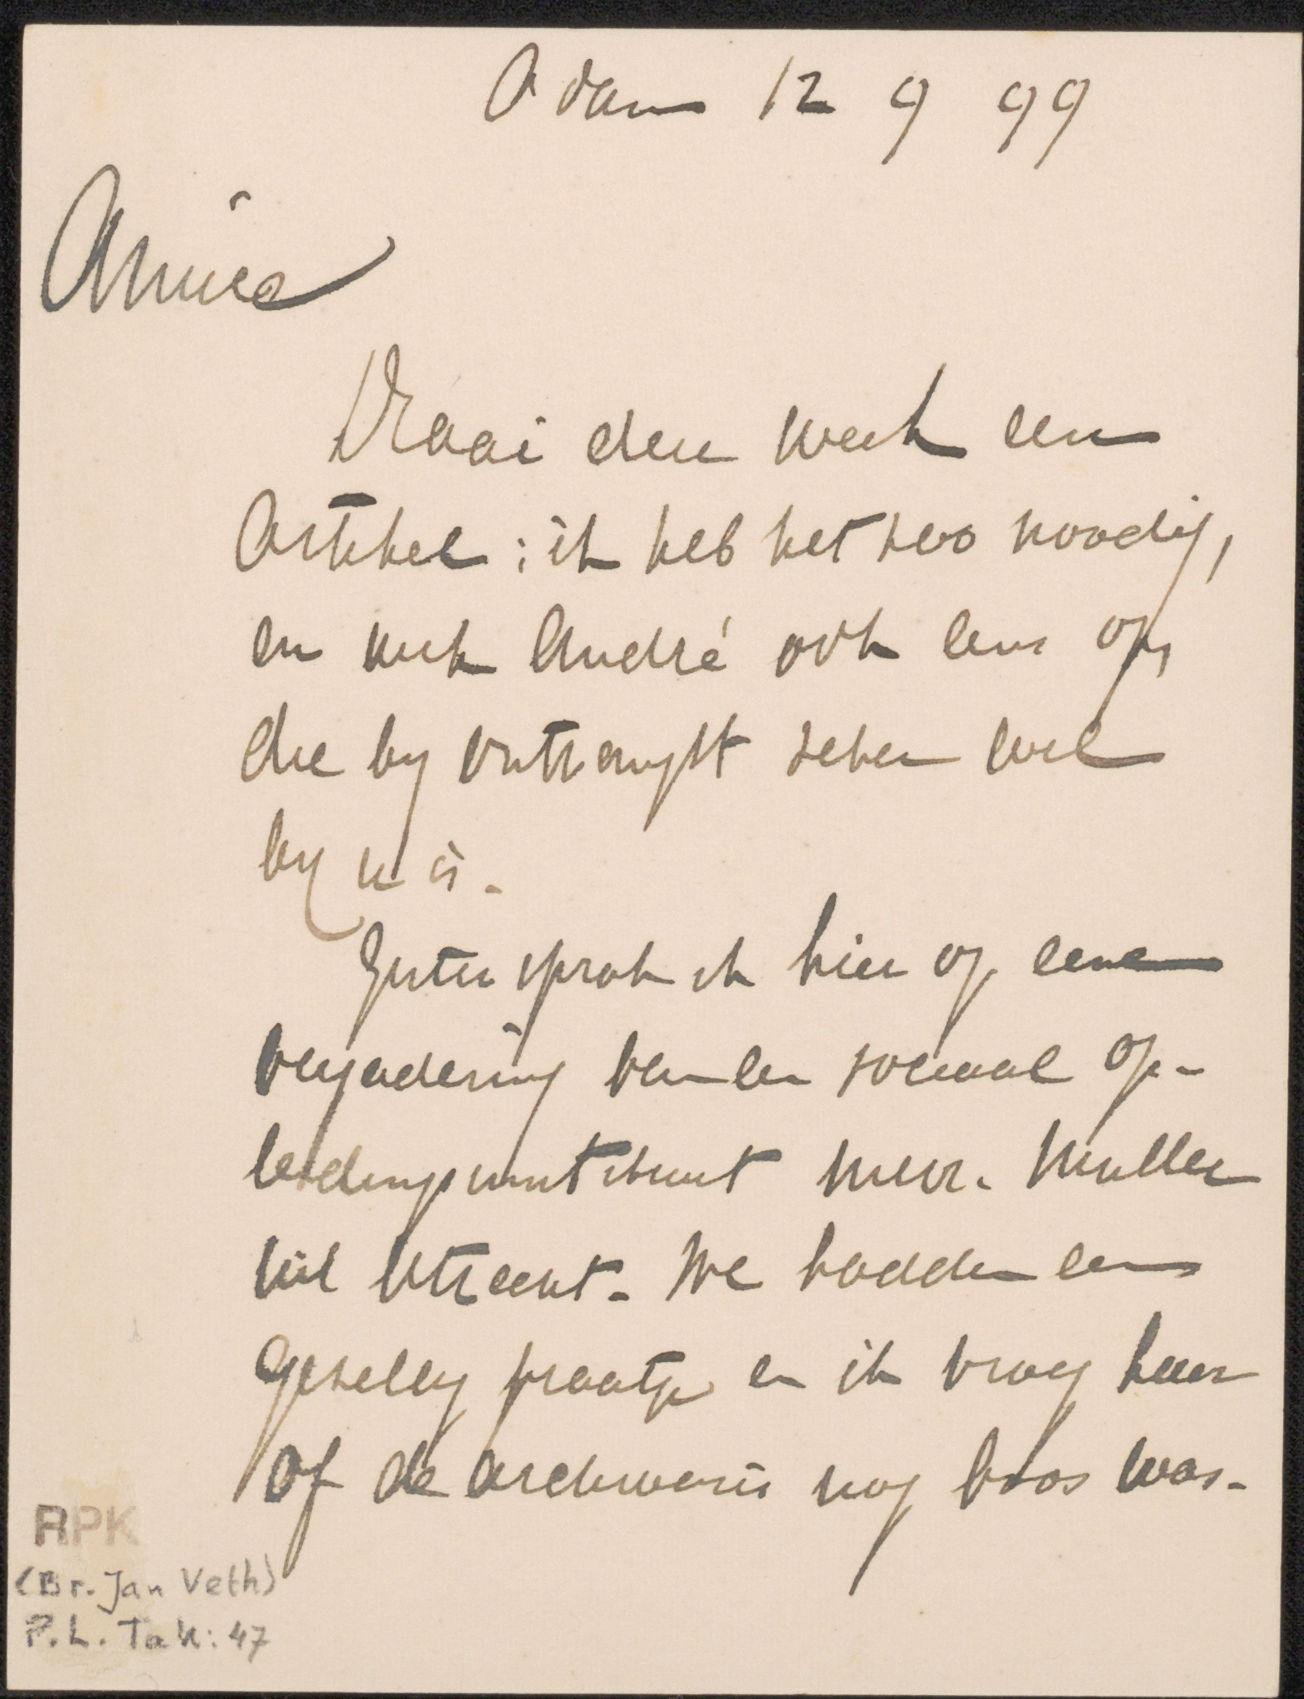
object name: letter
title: Brief aan Jan Veth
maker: pieter lodewijk tak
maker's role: politician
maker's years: 1848-1907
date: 1899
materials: cardboard, ink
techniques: pen, writing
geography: amsterdam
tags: dordrecht, amsterdam, painter, print maker, draughtsman, designer, jan veth, samuel muller (1848-1922), andré jolles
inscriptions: collector's mark: ‘RPK’